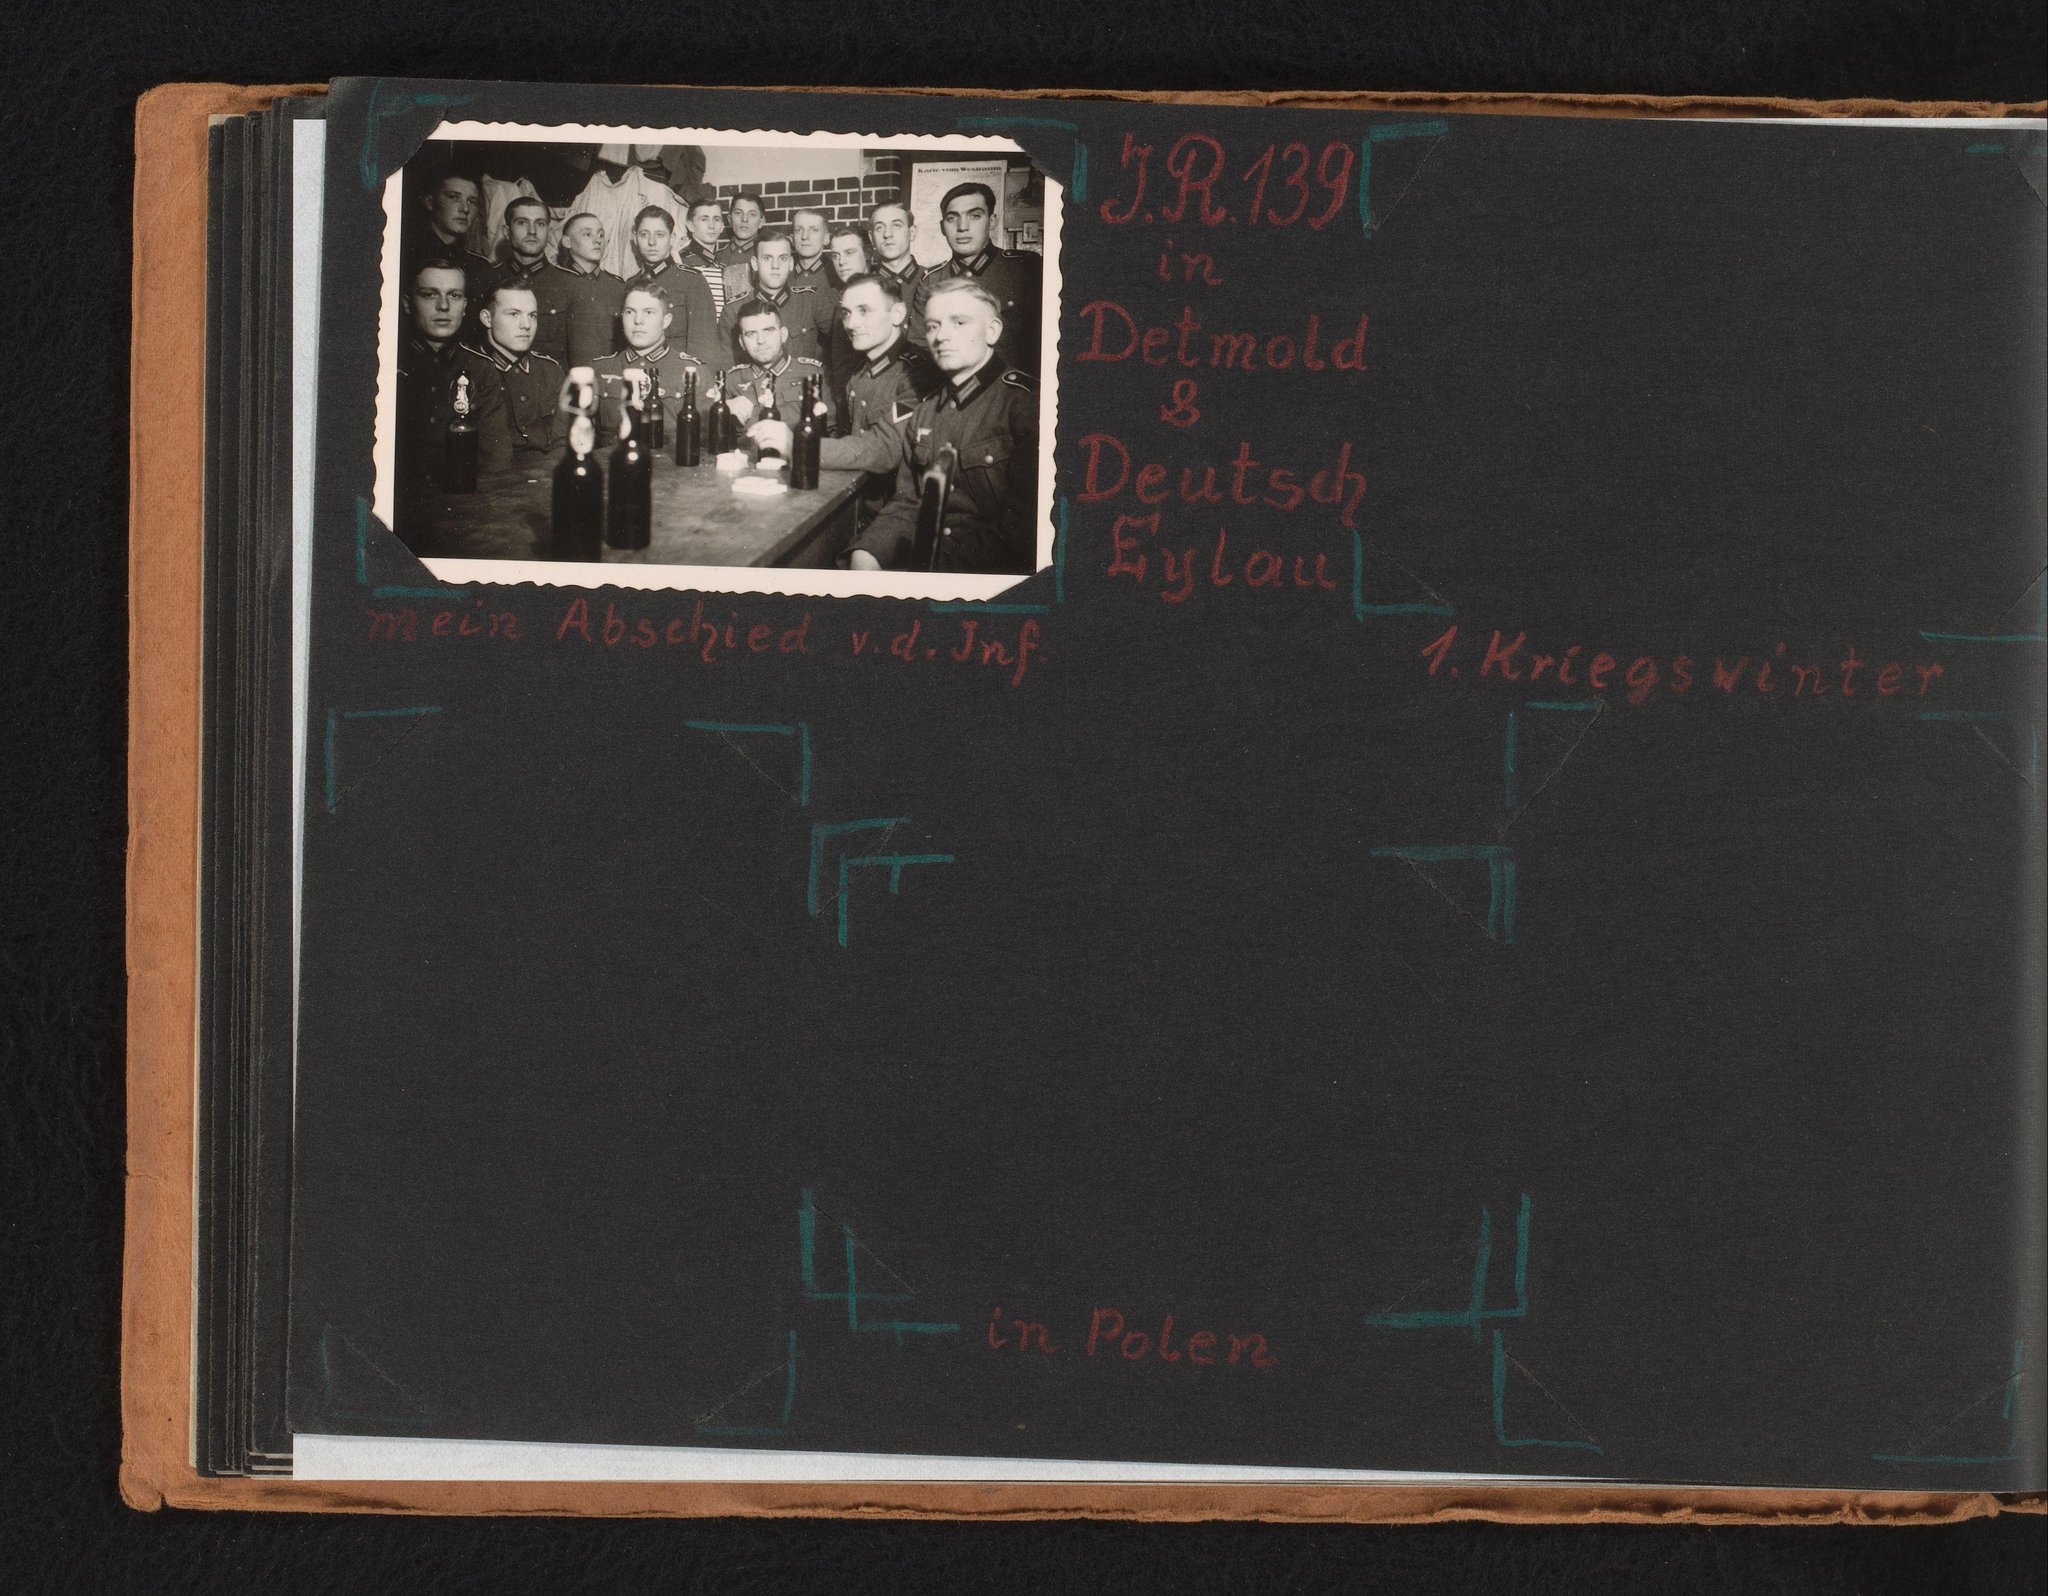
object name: album leaf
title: Opleiding 1940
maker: Anonymous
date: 1940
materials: paper, photographic support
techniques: gelatin silver print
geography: germany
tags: werner neufang, military training, germany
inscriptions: inscription: ‘Mein Abschied ... 8. 8. 40.’, inscription: ‘I.R. 139 in Detmold & Deutsch Eylau ...’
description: Albumblad een foto van Werner tijdens zijn militaire opleiding, afscheid van de Infanterie, 8 augustus 1940. De overige vier foto's die oorspronkelijk op dit blad zaten ingestoken ontbreken. Onderdeel van een fotoalbum over de Duitse Werner Neufang van de Kriegsmarine en de Nederlandse Thea Driesen.